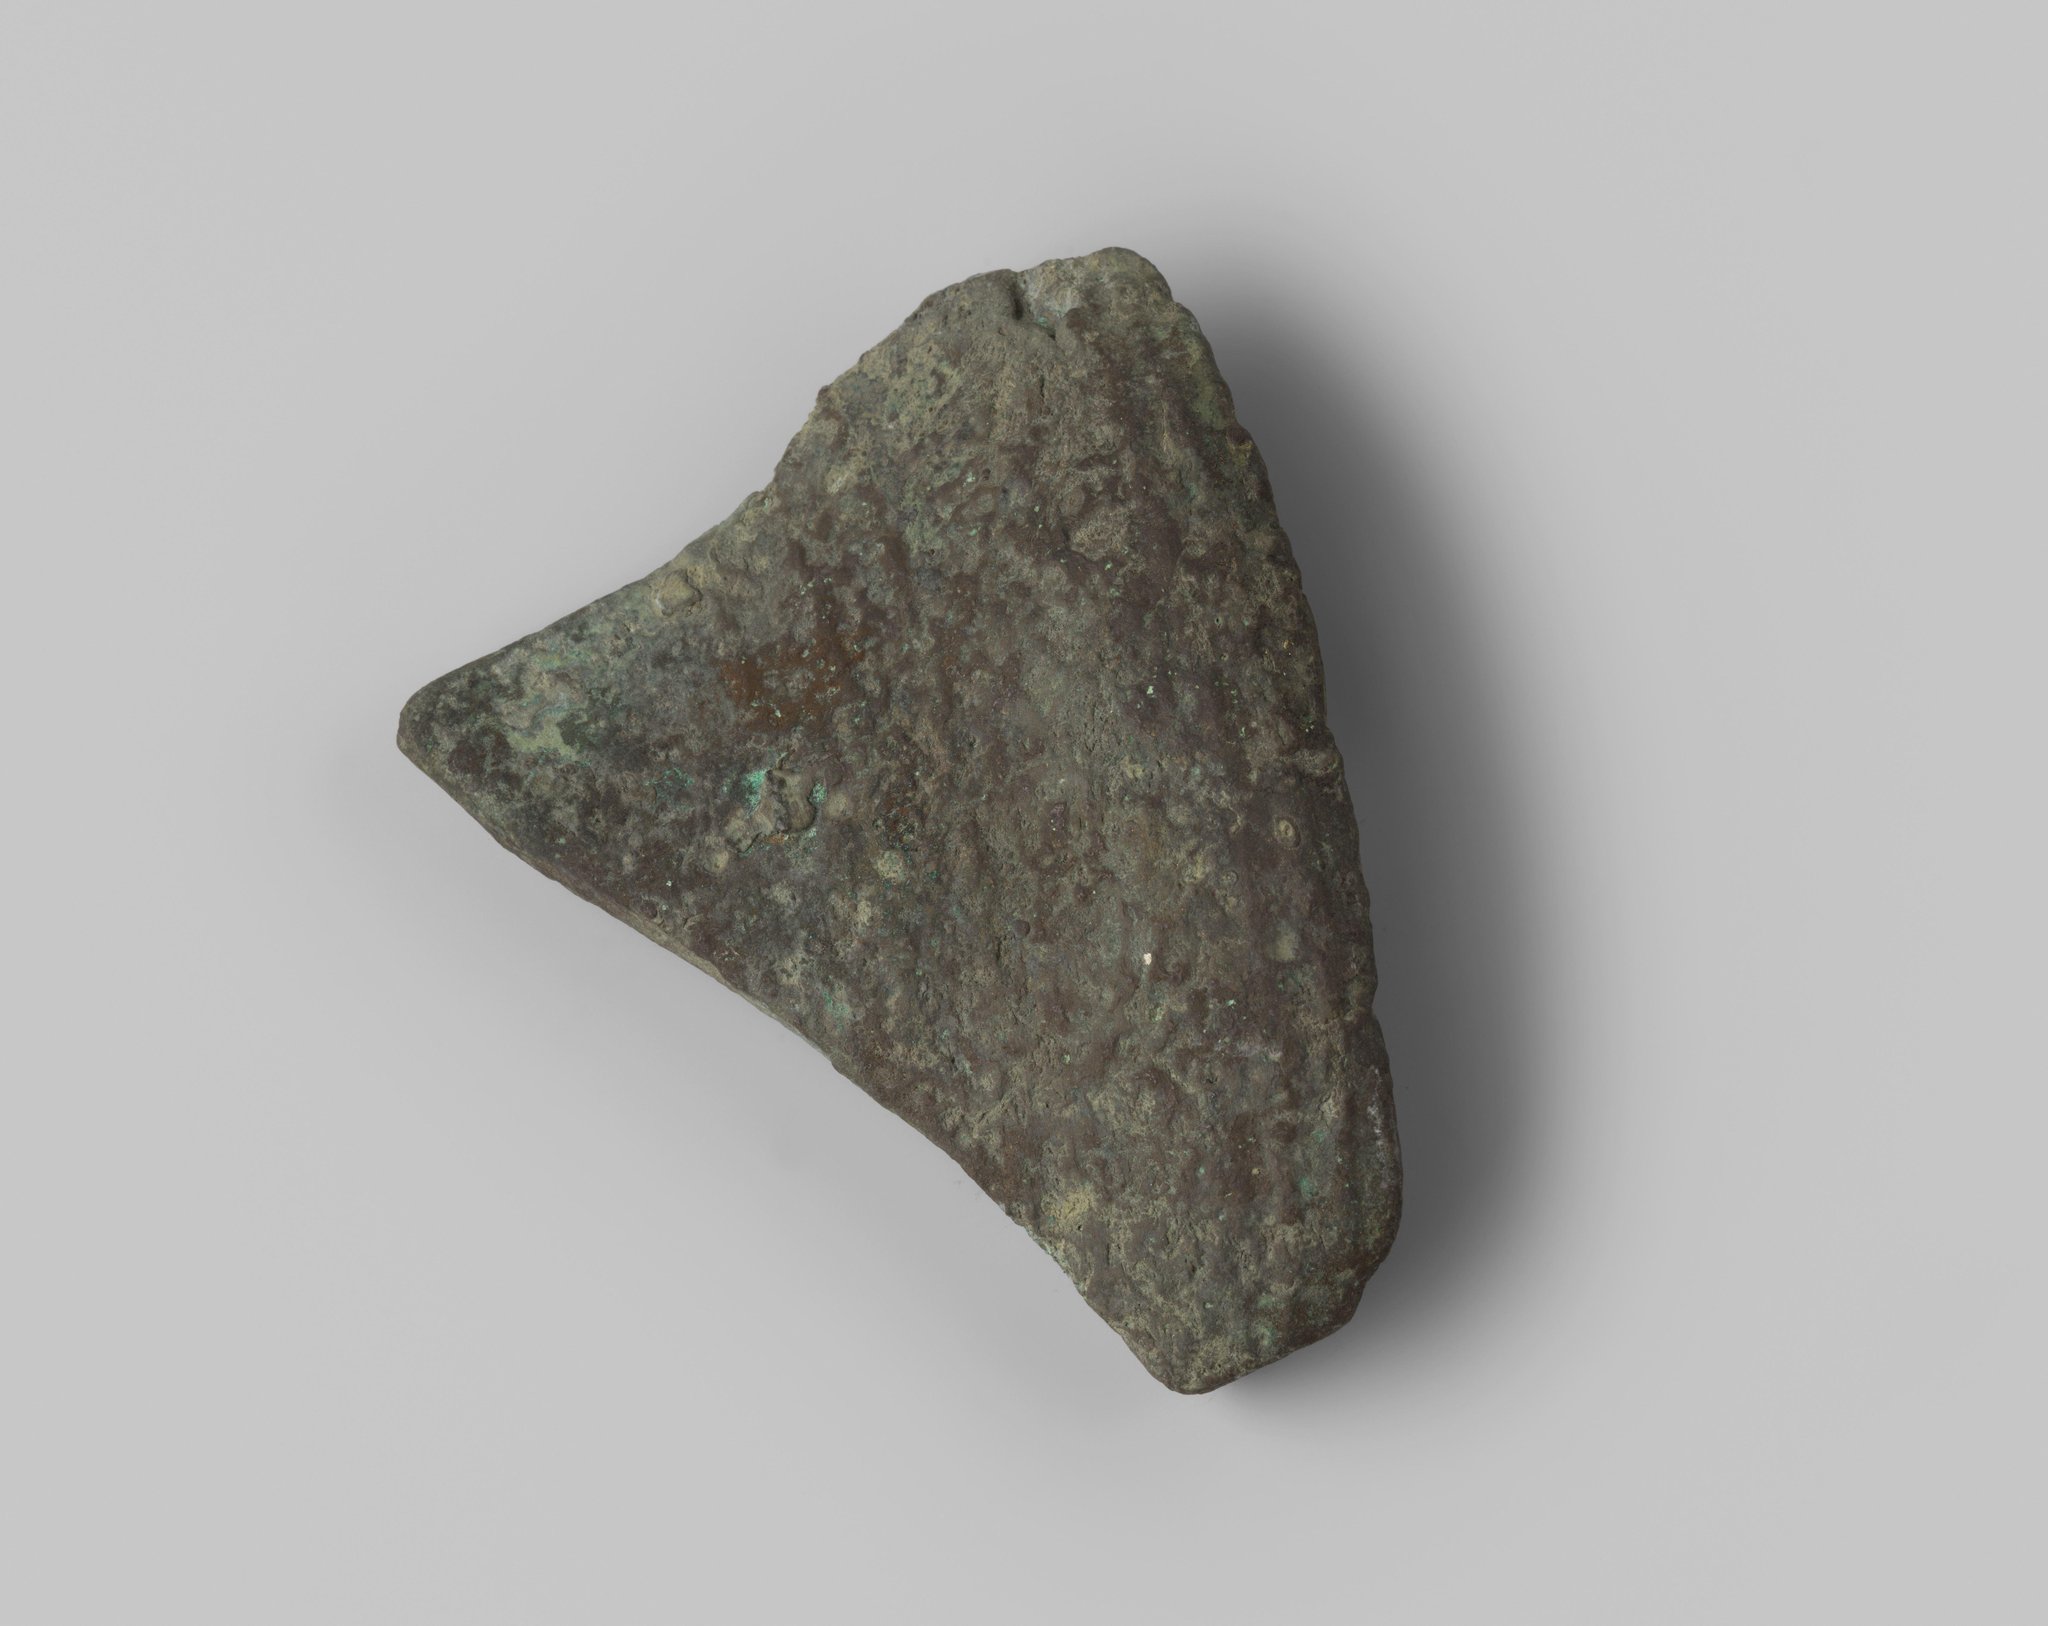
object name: ship bell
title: Fragment scheepsbel uit het wrak van de Oost-Indiëvaarder Hollandia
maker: Anonymous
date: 1700-1743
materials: copper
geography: netherlands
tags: verenigde oostindische compagnie, hollandia (schip), annet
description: Acoustic, bell (ship's); fragment of rim, eroded, concentric band moulding, fits to NG 1980-27H2990/830/3010a.